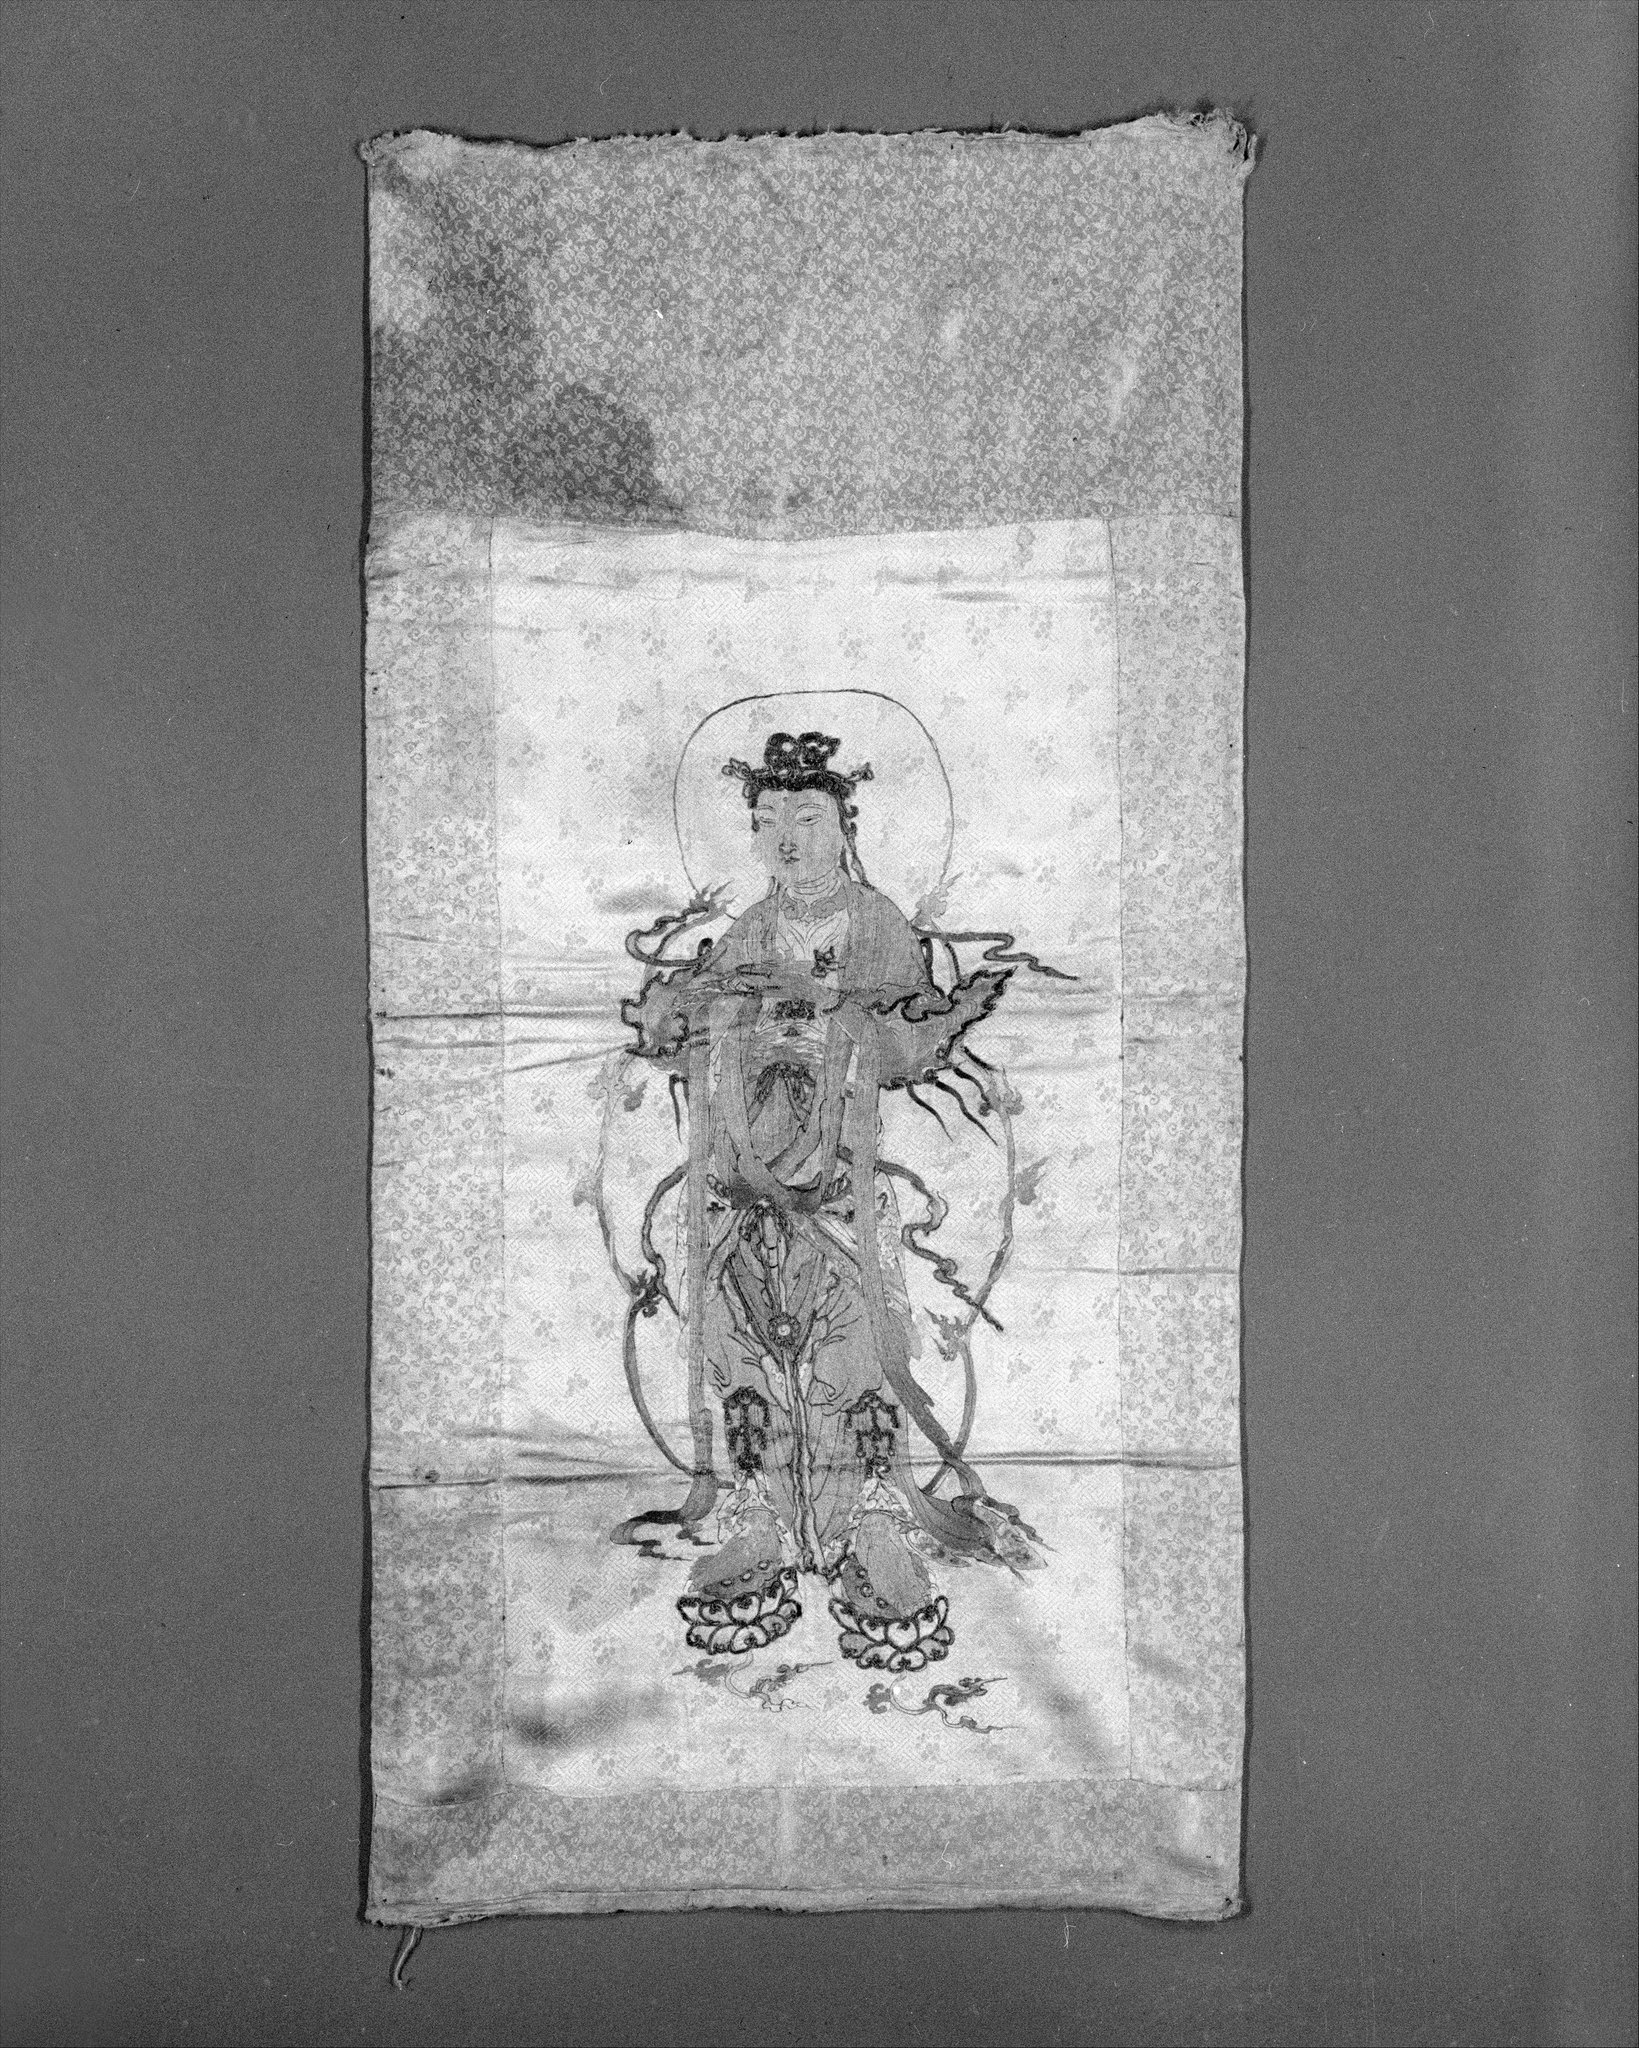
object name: panel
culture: chinese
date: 1567-1633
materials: cotton, metal thread, silk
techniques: backing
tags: bodhisattvas